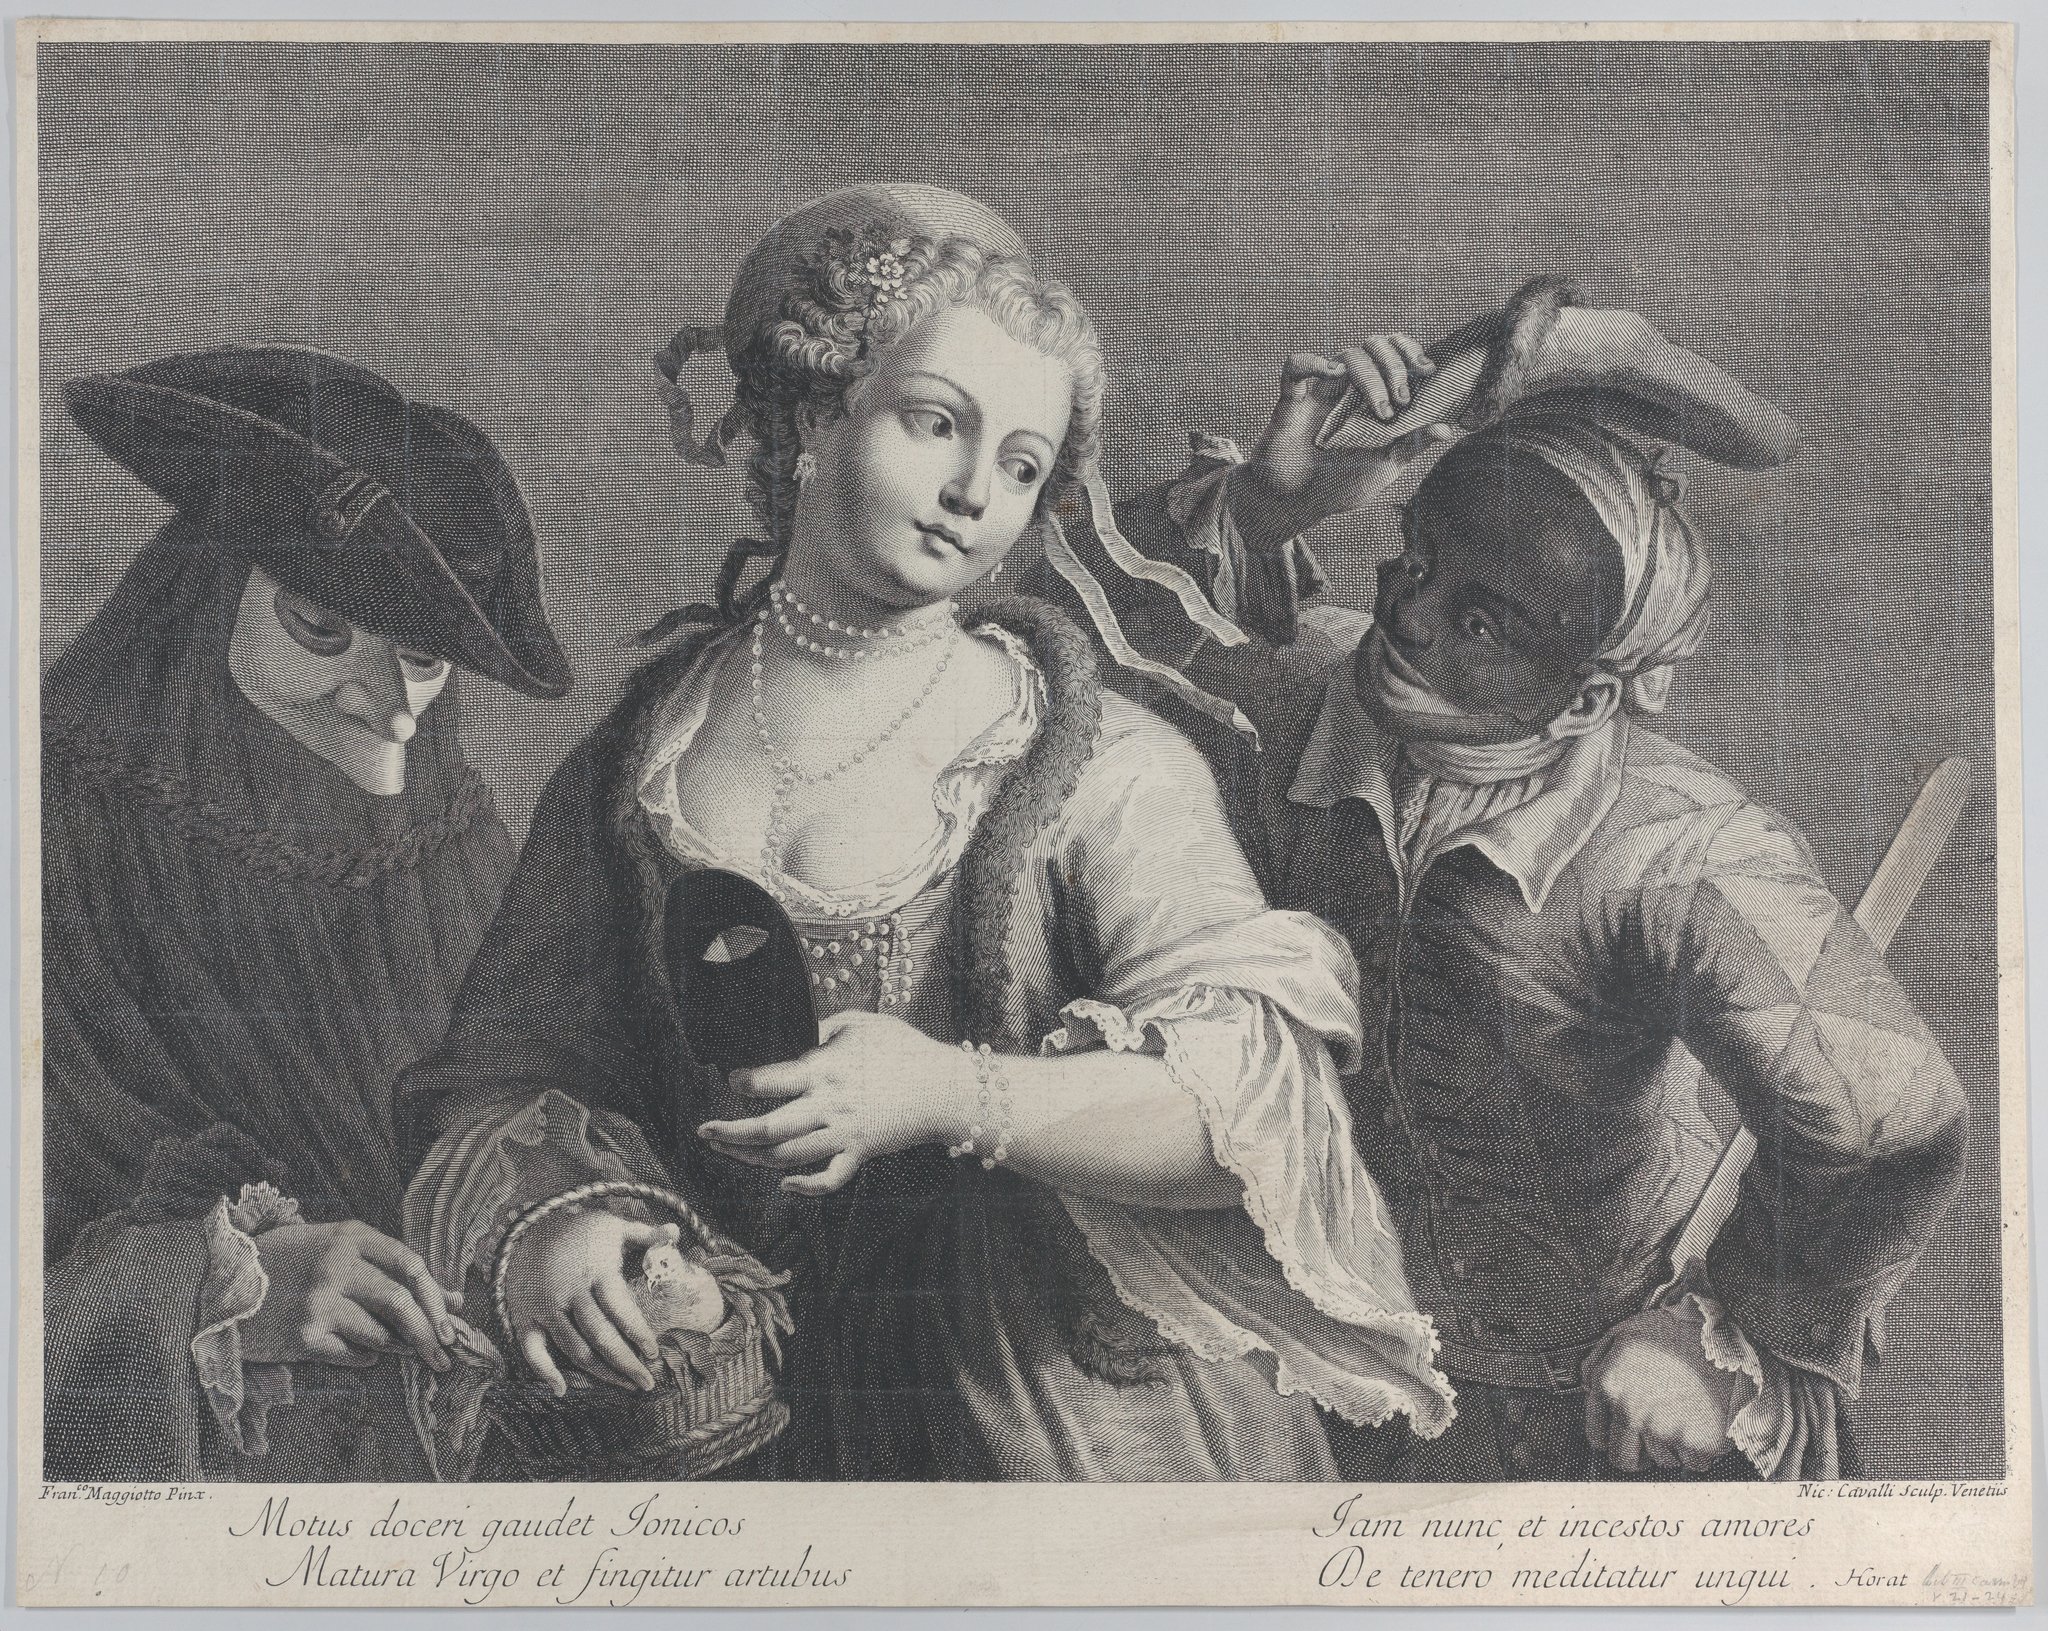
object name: print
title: Three half-length figures from a Venetian carnival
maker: niccolò cavalli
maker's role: artist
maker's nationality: italian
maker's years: 1730-1822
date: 1750-1822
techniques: engraving, etching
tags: masks,men,women